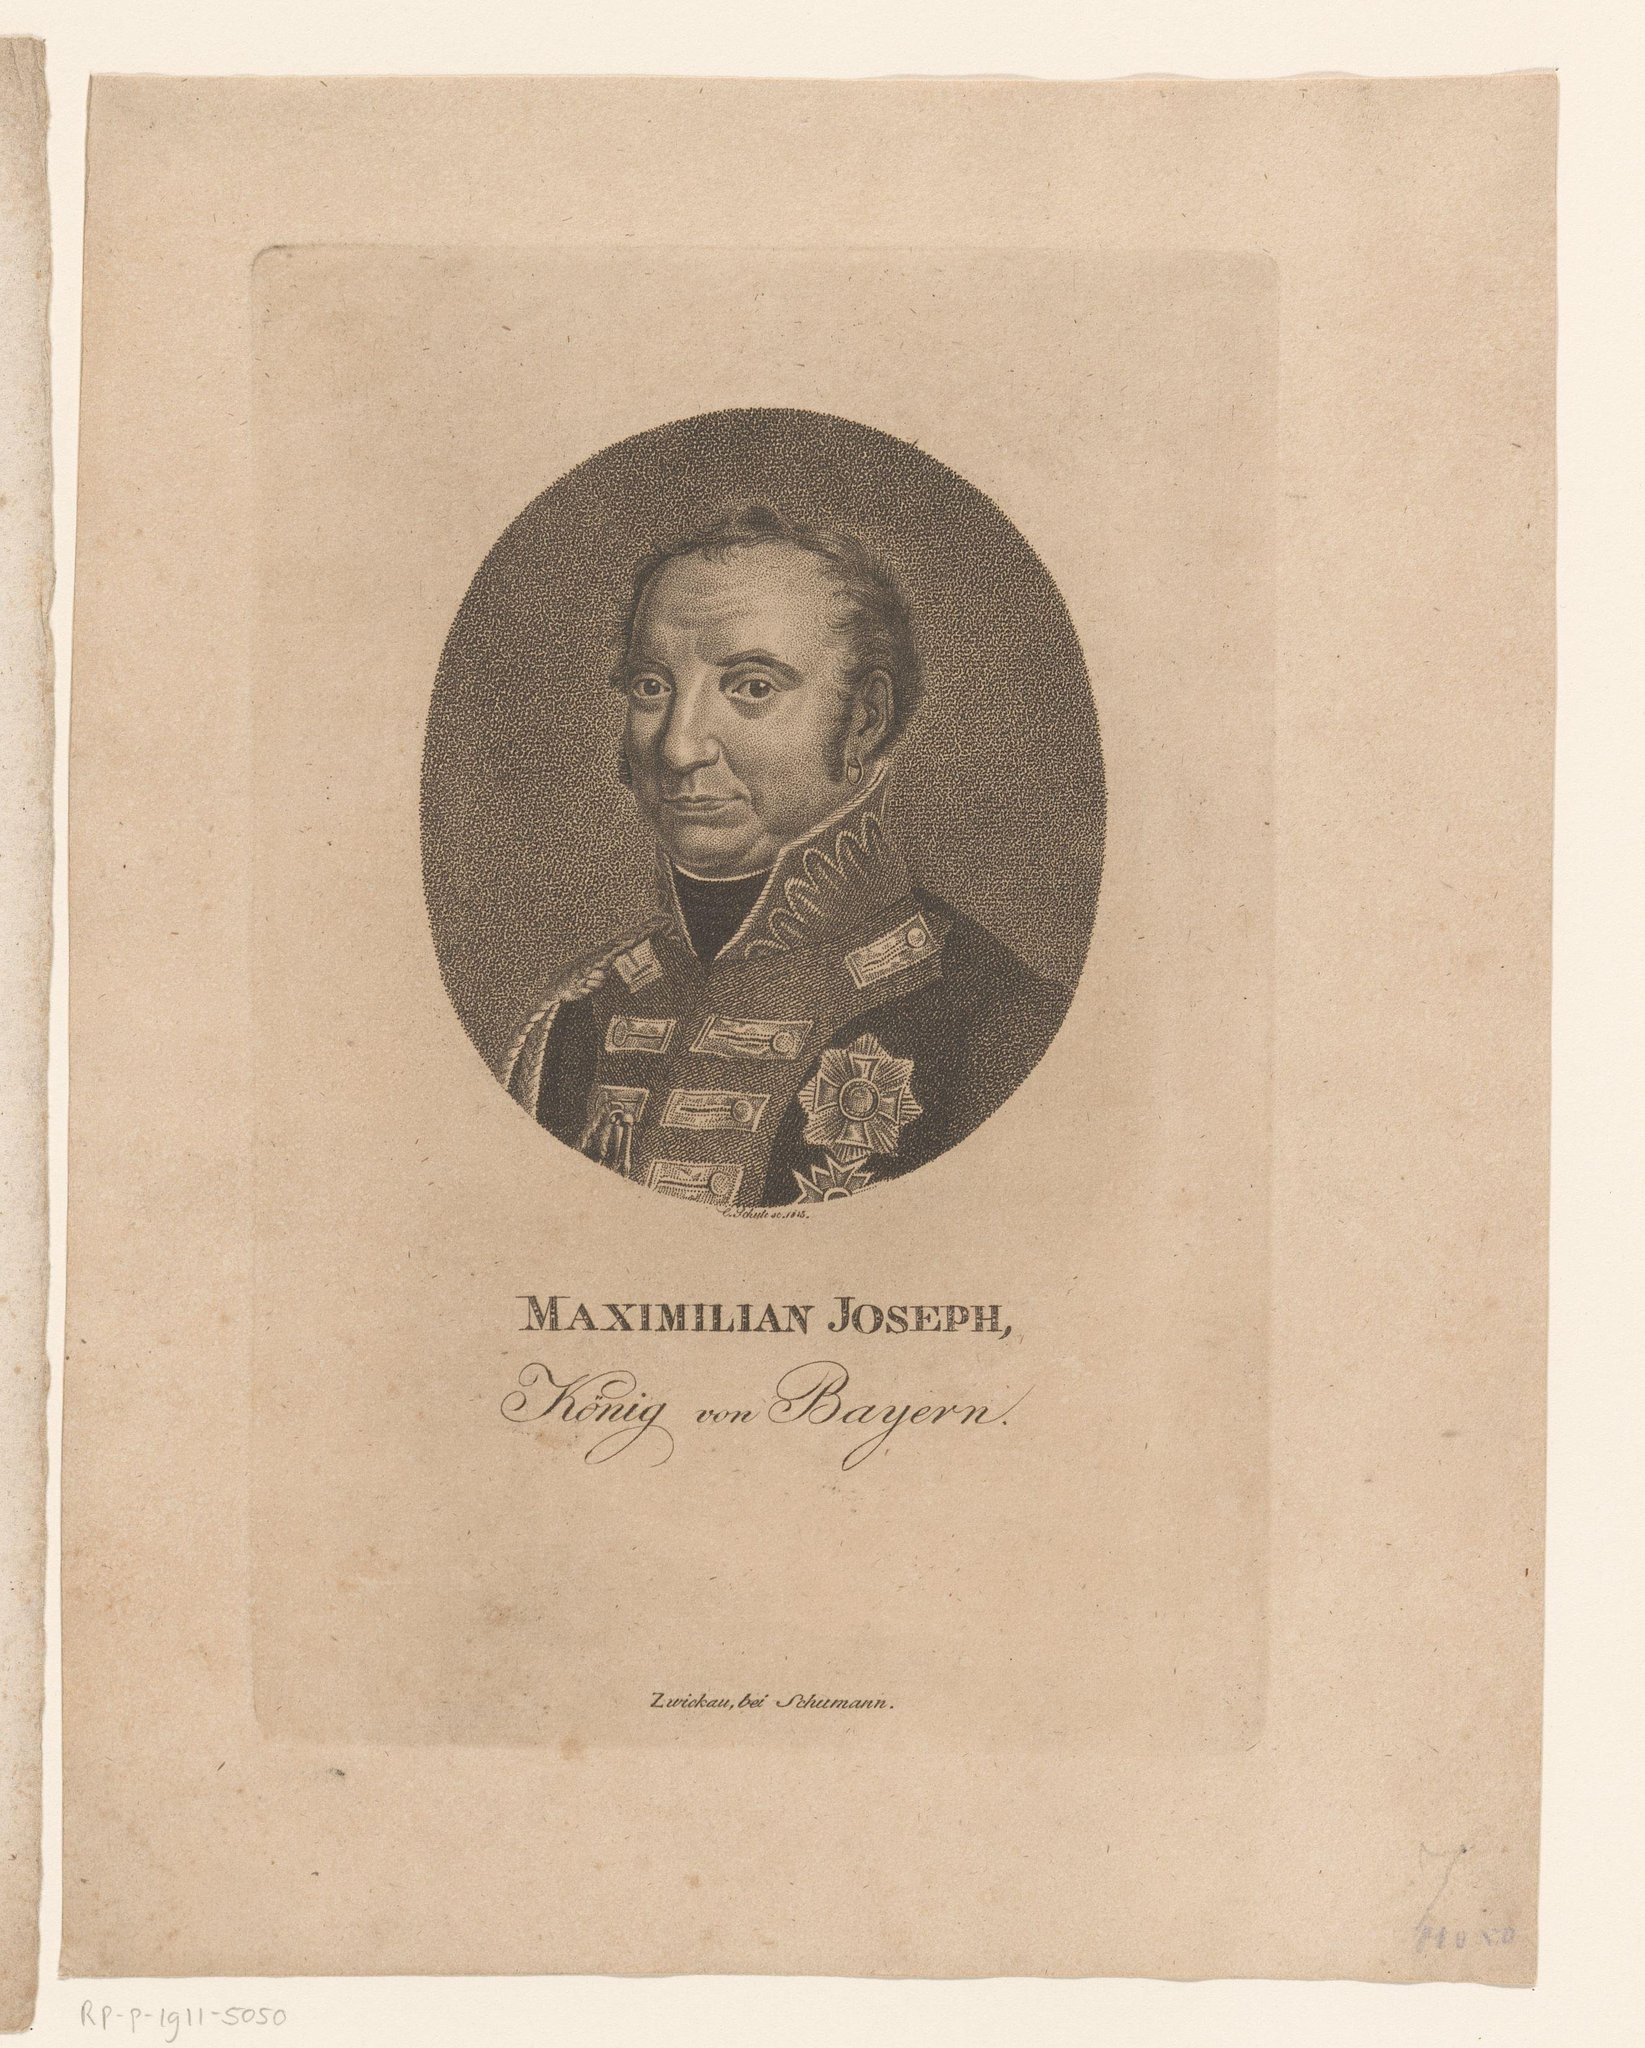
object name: print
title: Maximilian Joseph, König von Bayern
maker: christian schule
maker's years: 1764-1816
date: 1815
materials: paper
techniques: etching, engraving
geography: zwickau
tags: maximiliaan i jozef (koning van beieren), historical persons, king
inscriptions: collector's mark: Lugt 2228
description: Potret van koning Maximiliaan I Jozef van Beieren.